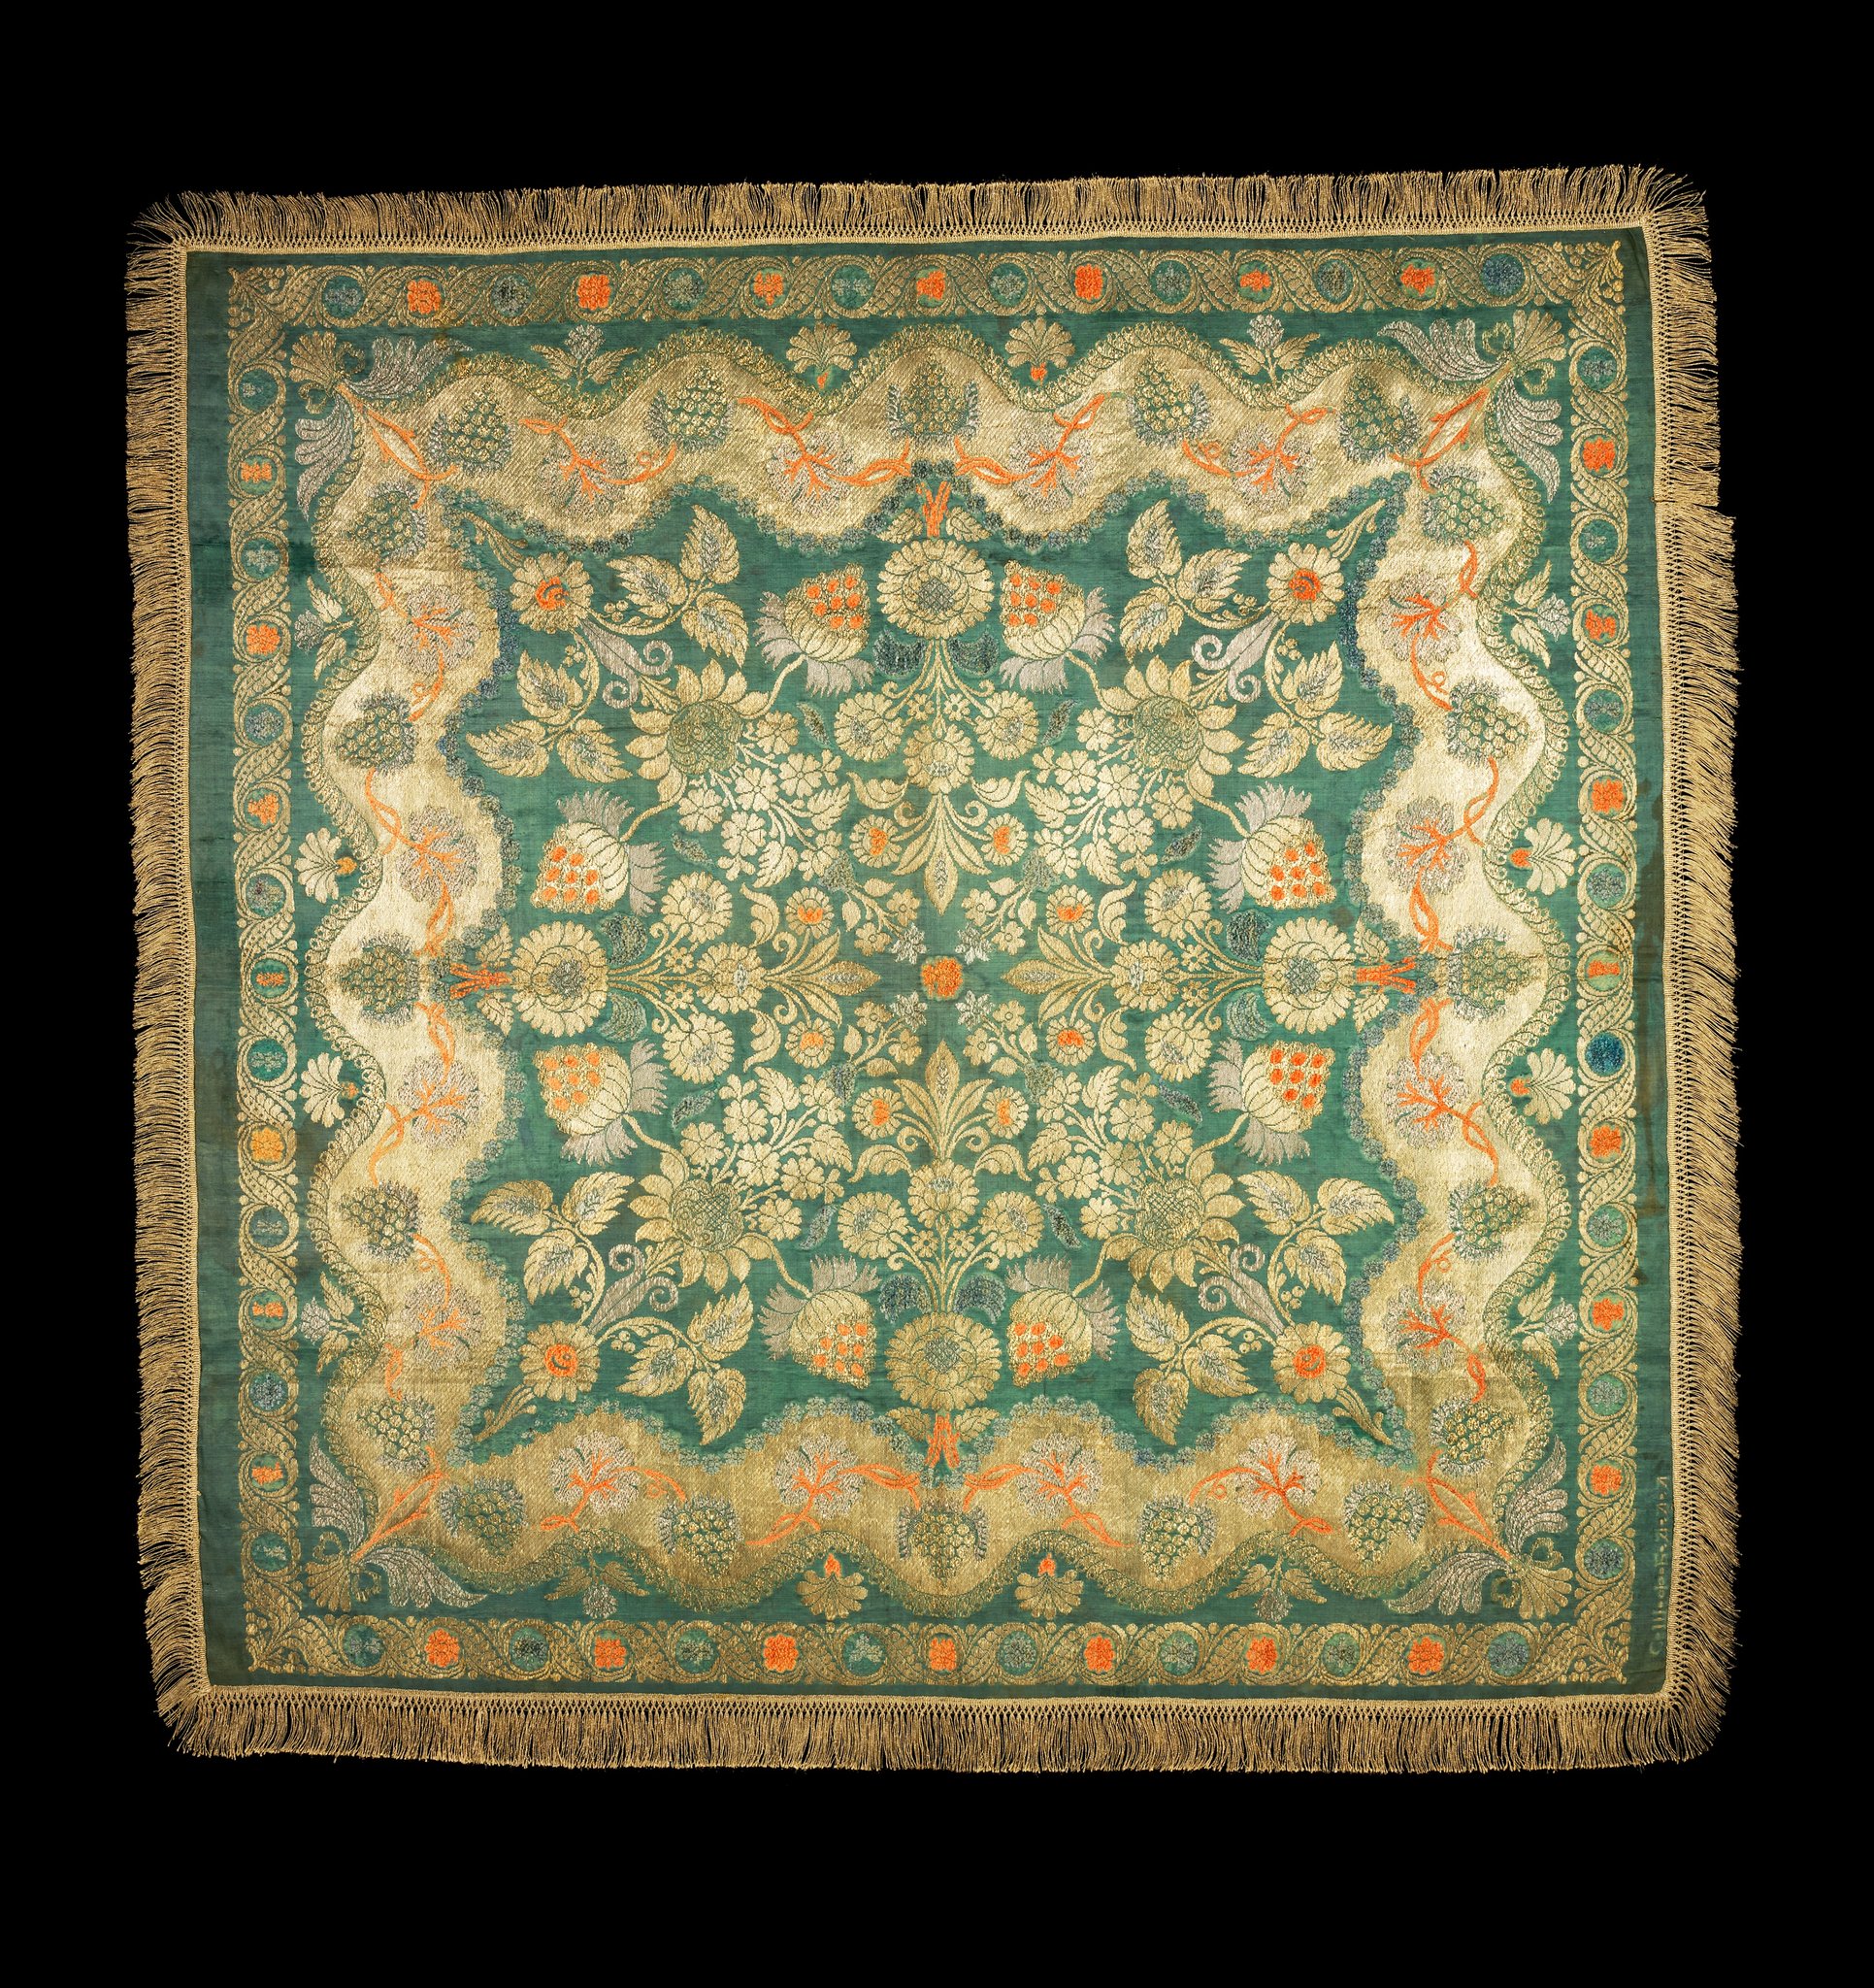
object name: headscarf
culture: russian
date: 1801-1825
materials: metal, silk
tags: flowers